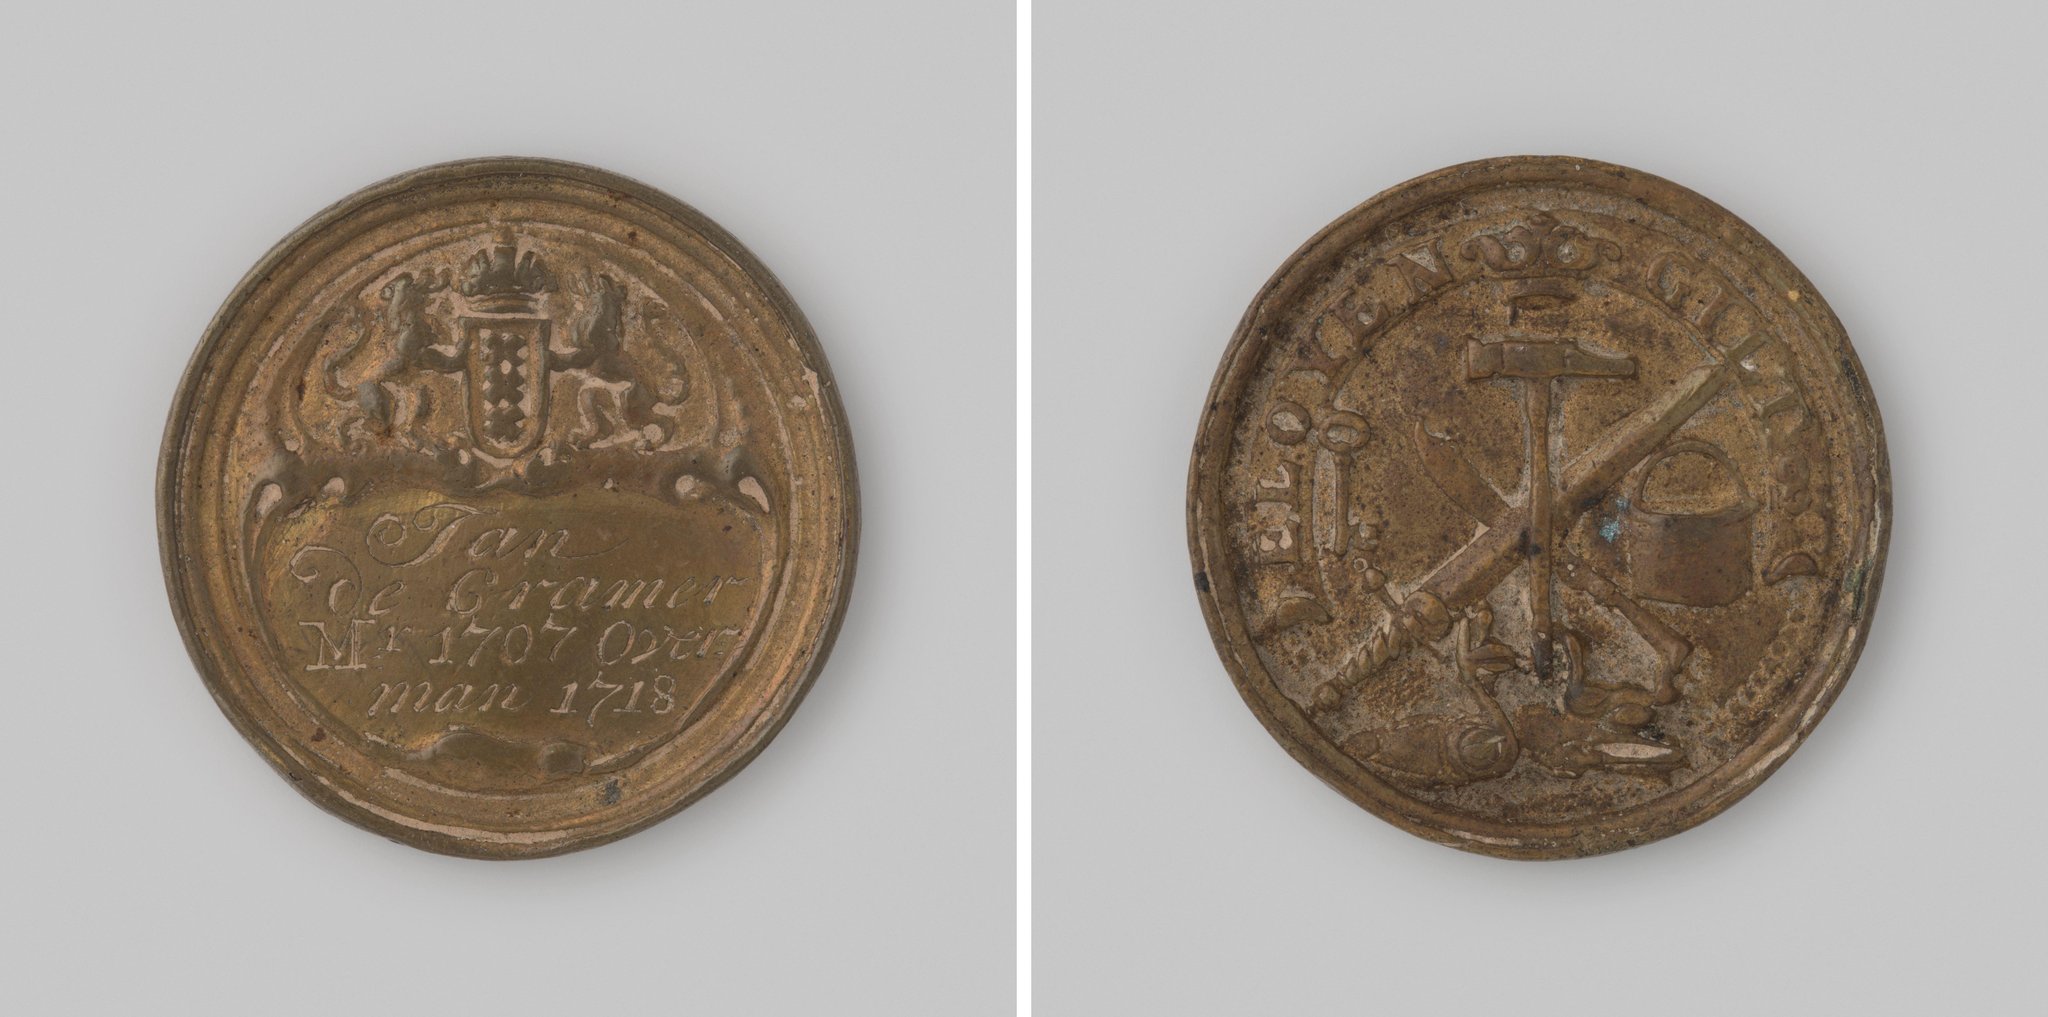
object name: medal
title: Smiths’ Guild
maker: Anonymous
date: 1718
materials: brass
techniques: casting, engraving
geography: amsterdam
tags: goldsmith, amsterdam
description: Guild medals Members of trade guilds had to identify themselves with a medal at their meetings.